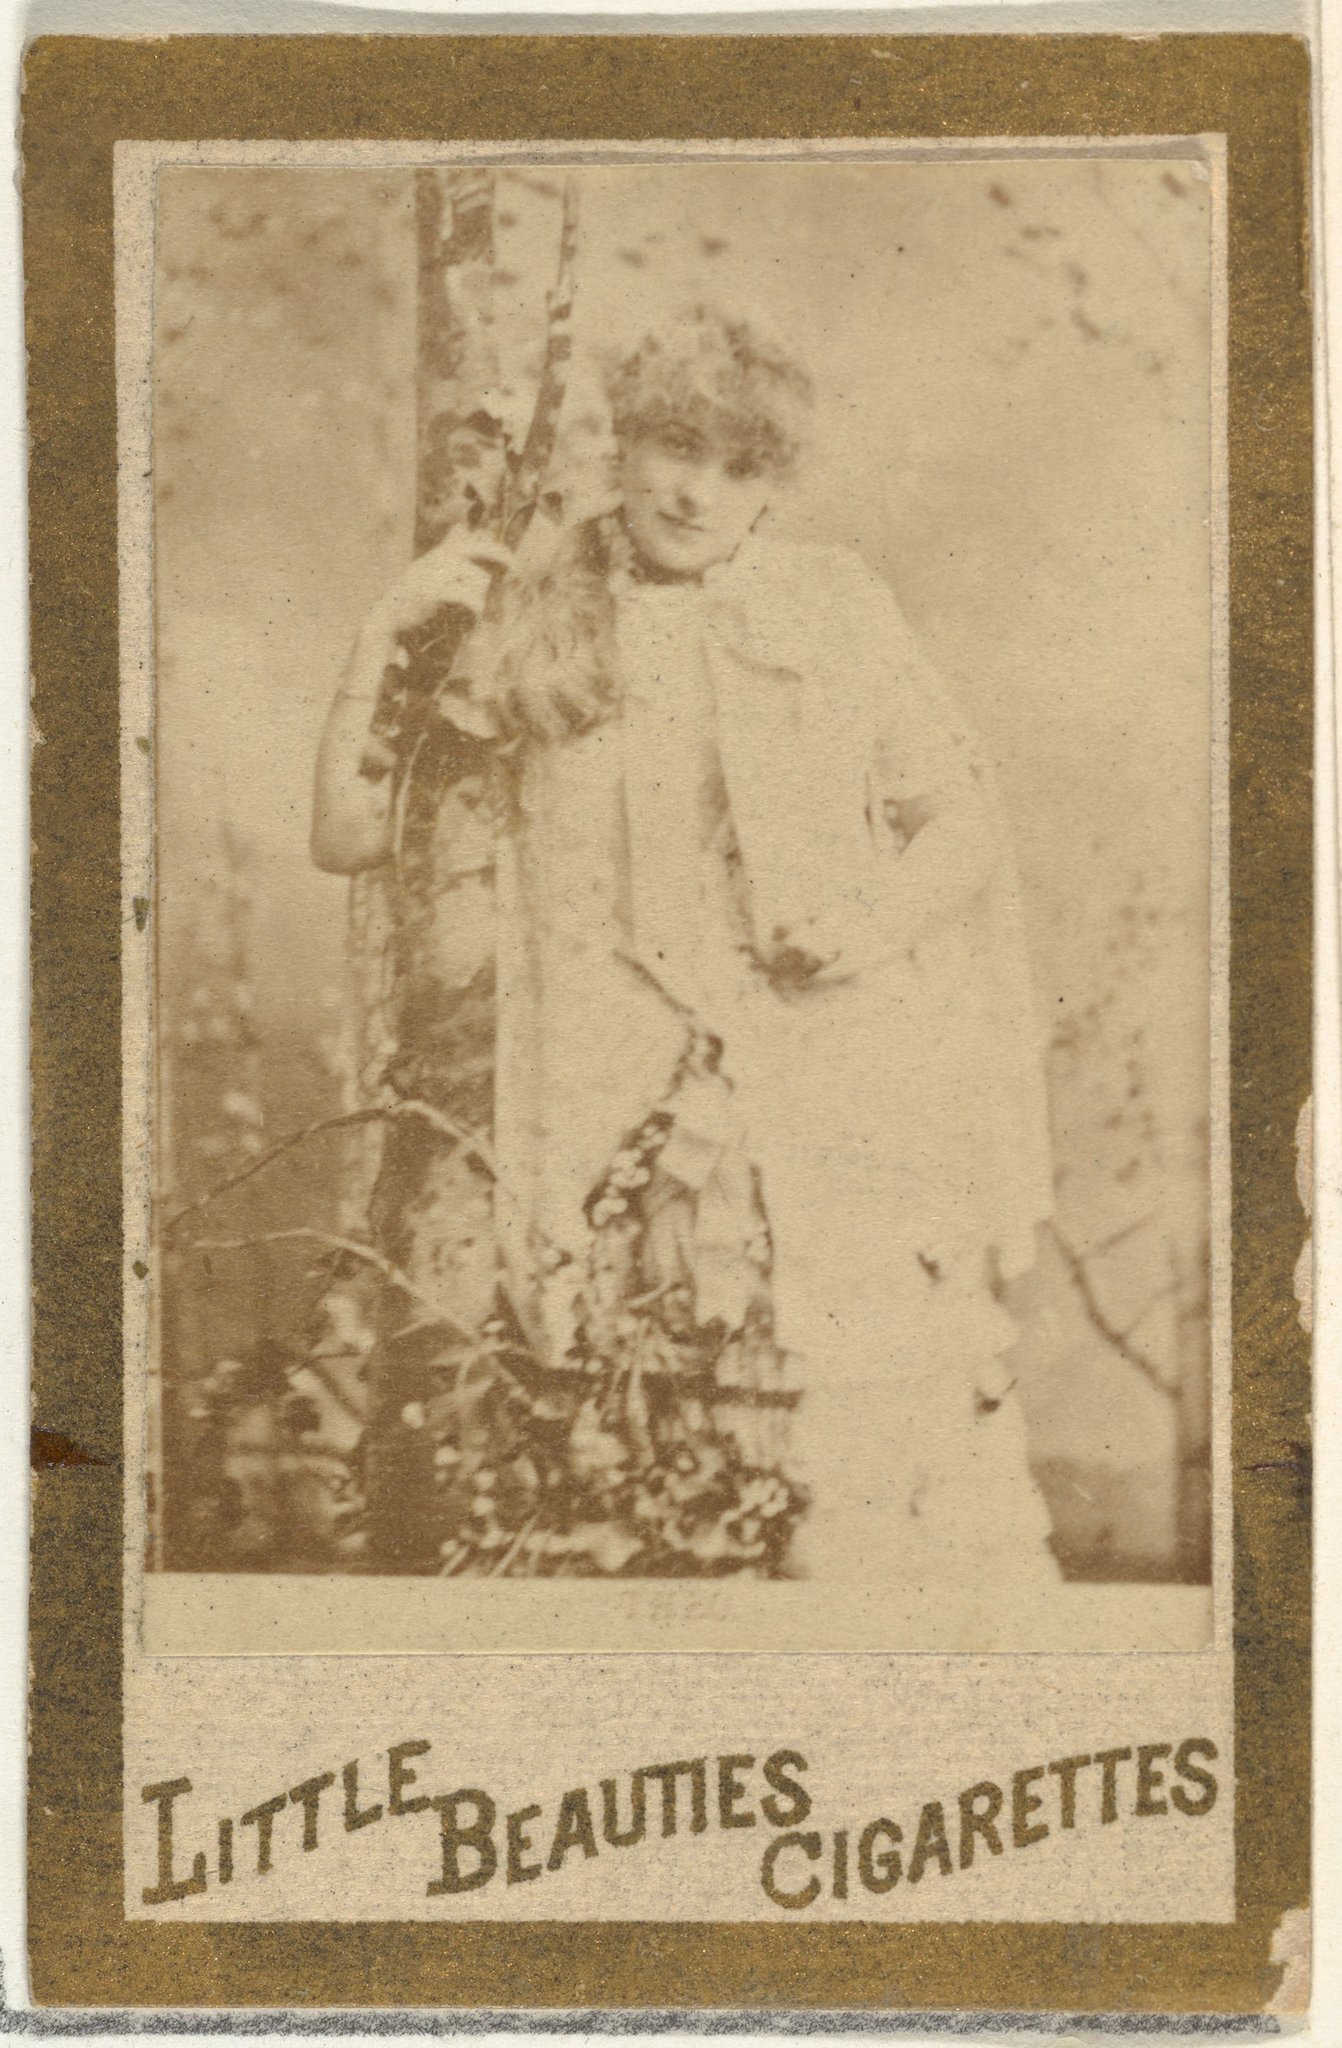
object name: photograph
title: From the Actresses and Celebrities series (N60, Type 1) promoting Little Beauties Cigarettes for Allen & Ginter brand tobacco products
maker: allen & ginter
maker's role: publisher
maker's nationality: american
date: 1887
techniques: albumen silver print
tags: portraits,women,actresses